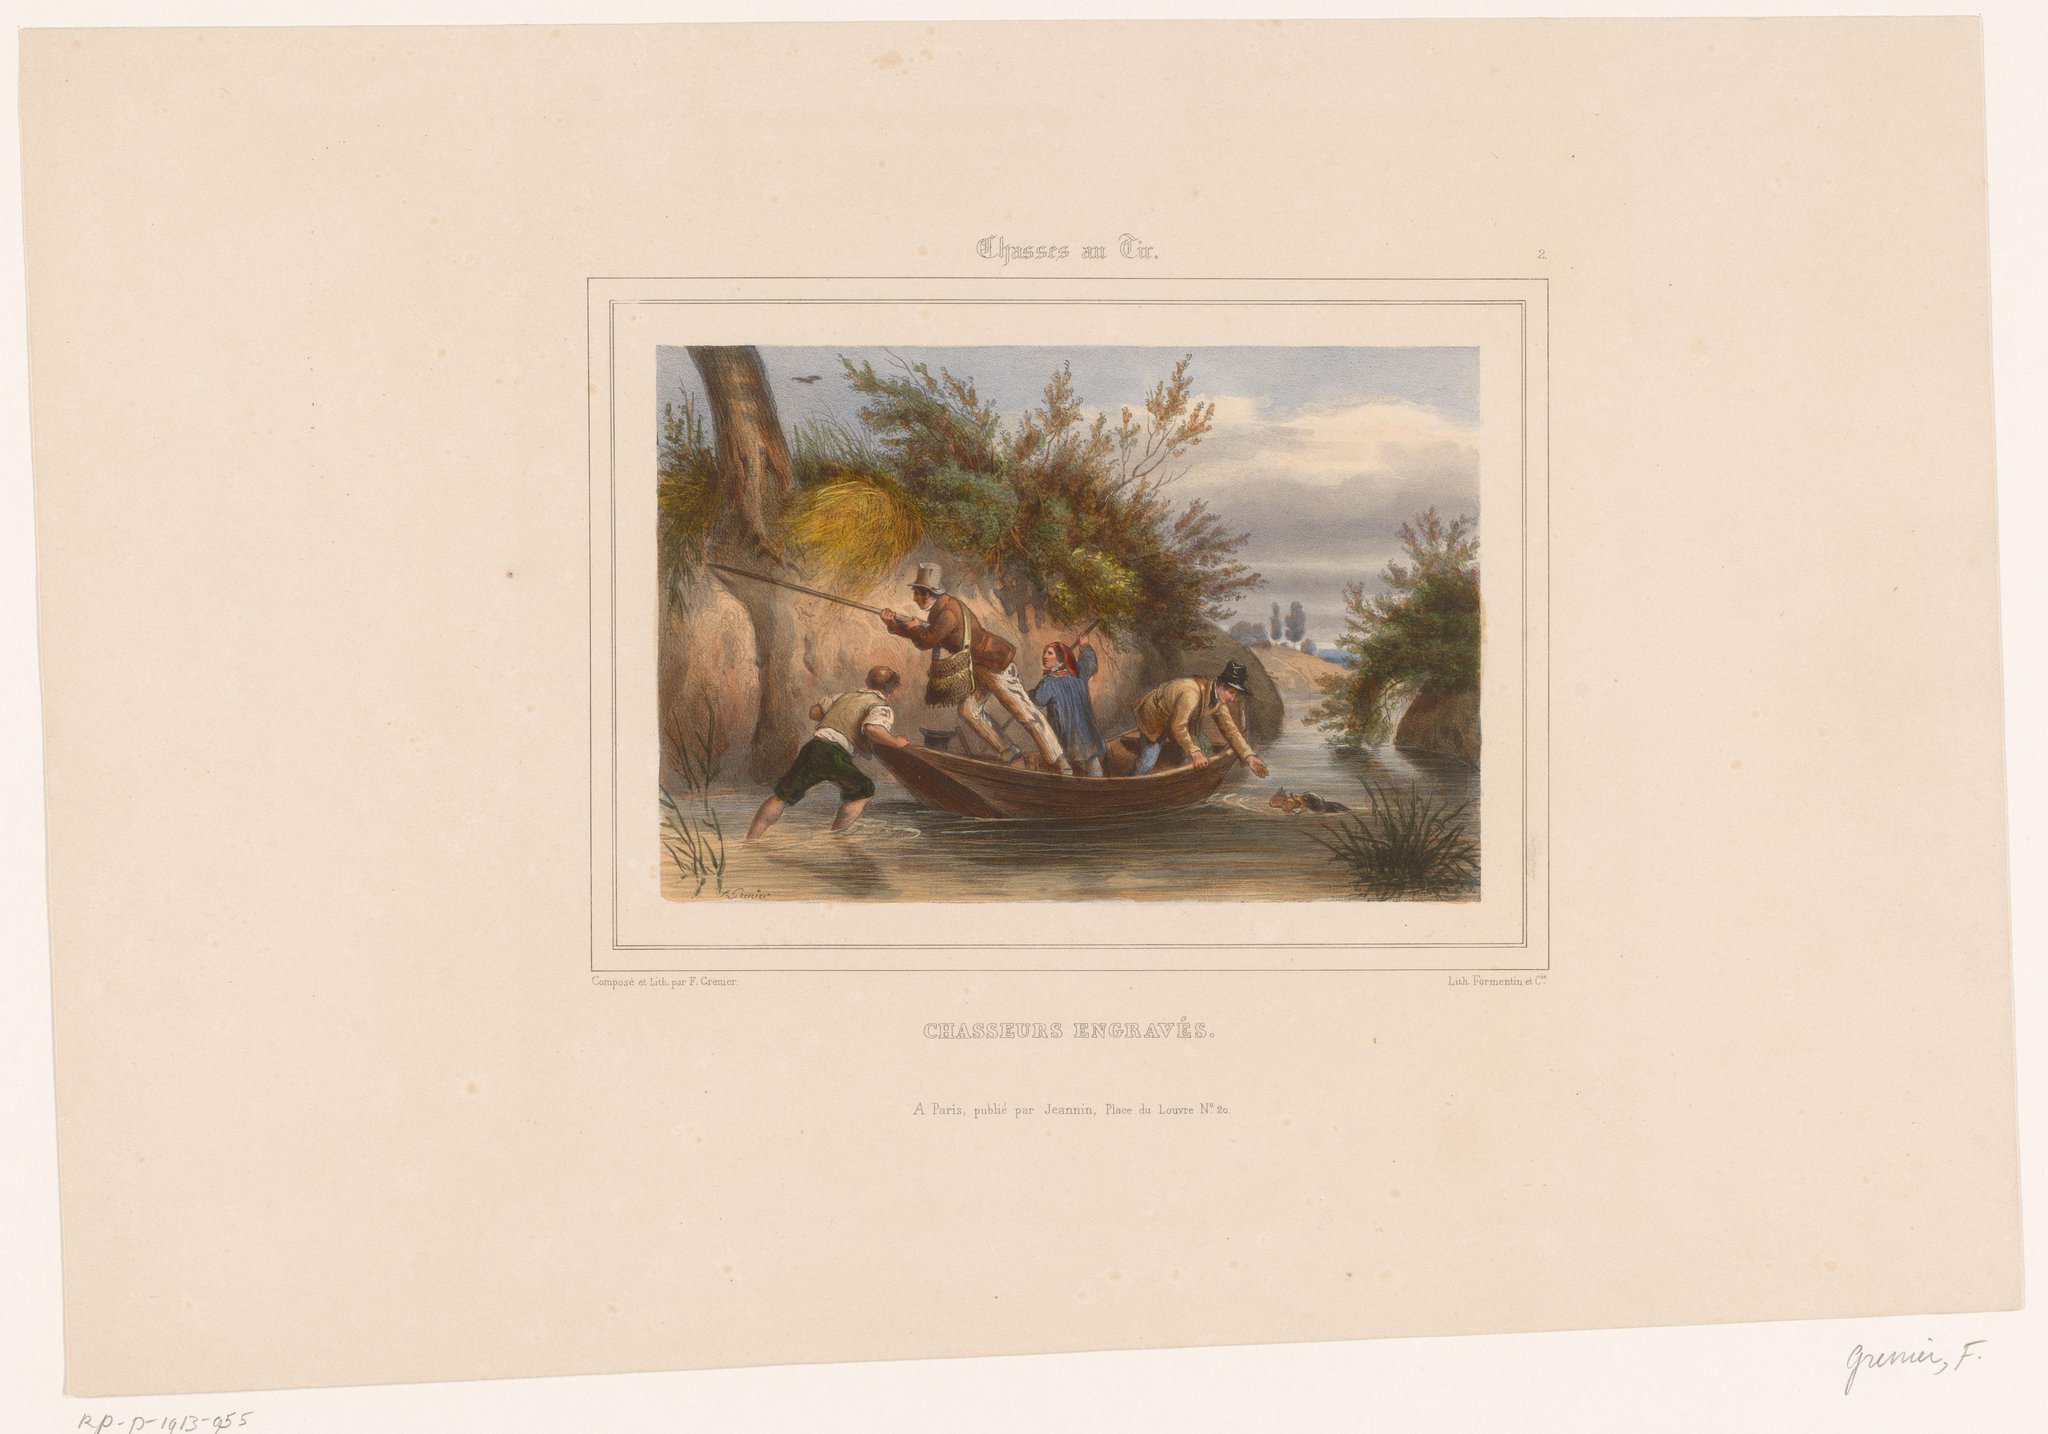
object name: print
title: Chasseurs engravés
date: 1831-1846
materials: paper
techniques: hand coloring, lithograph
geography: paris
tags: hunter, rowing-boat, canoe, etc., firearms: rifle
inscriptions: check stamp: Lugt 1397c, collector's mark: Lugt 2228a